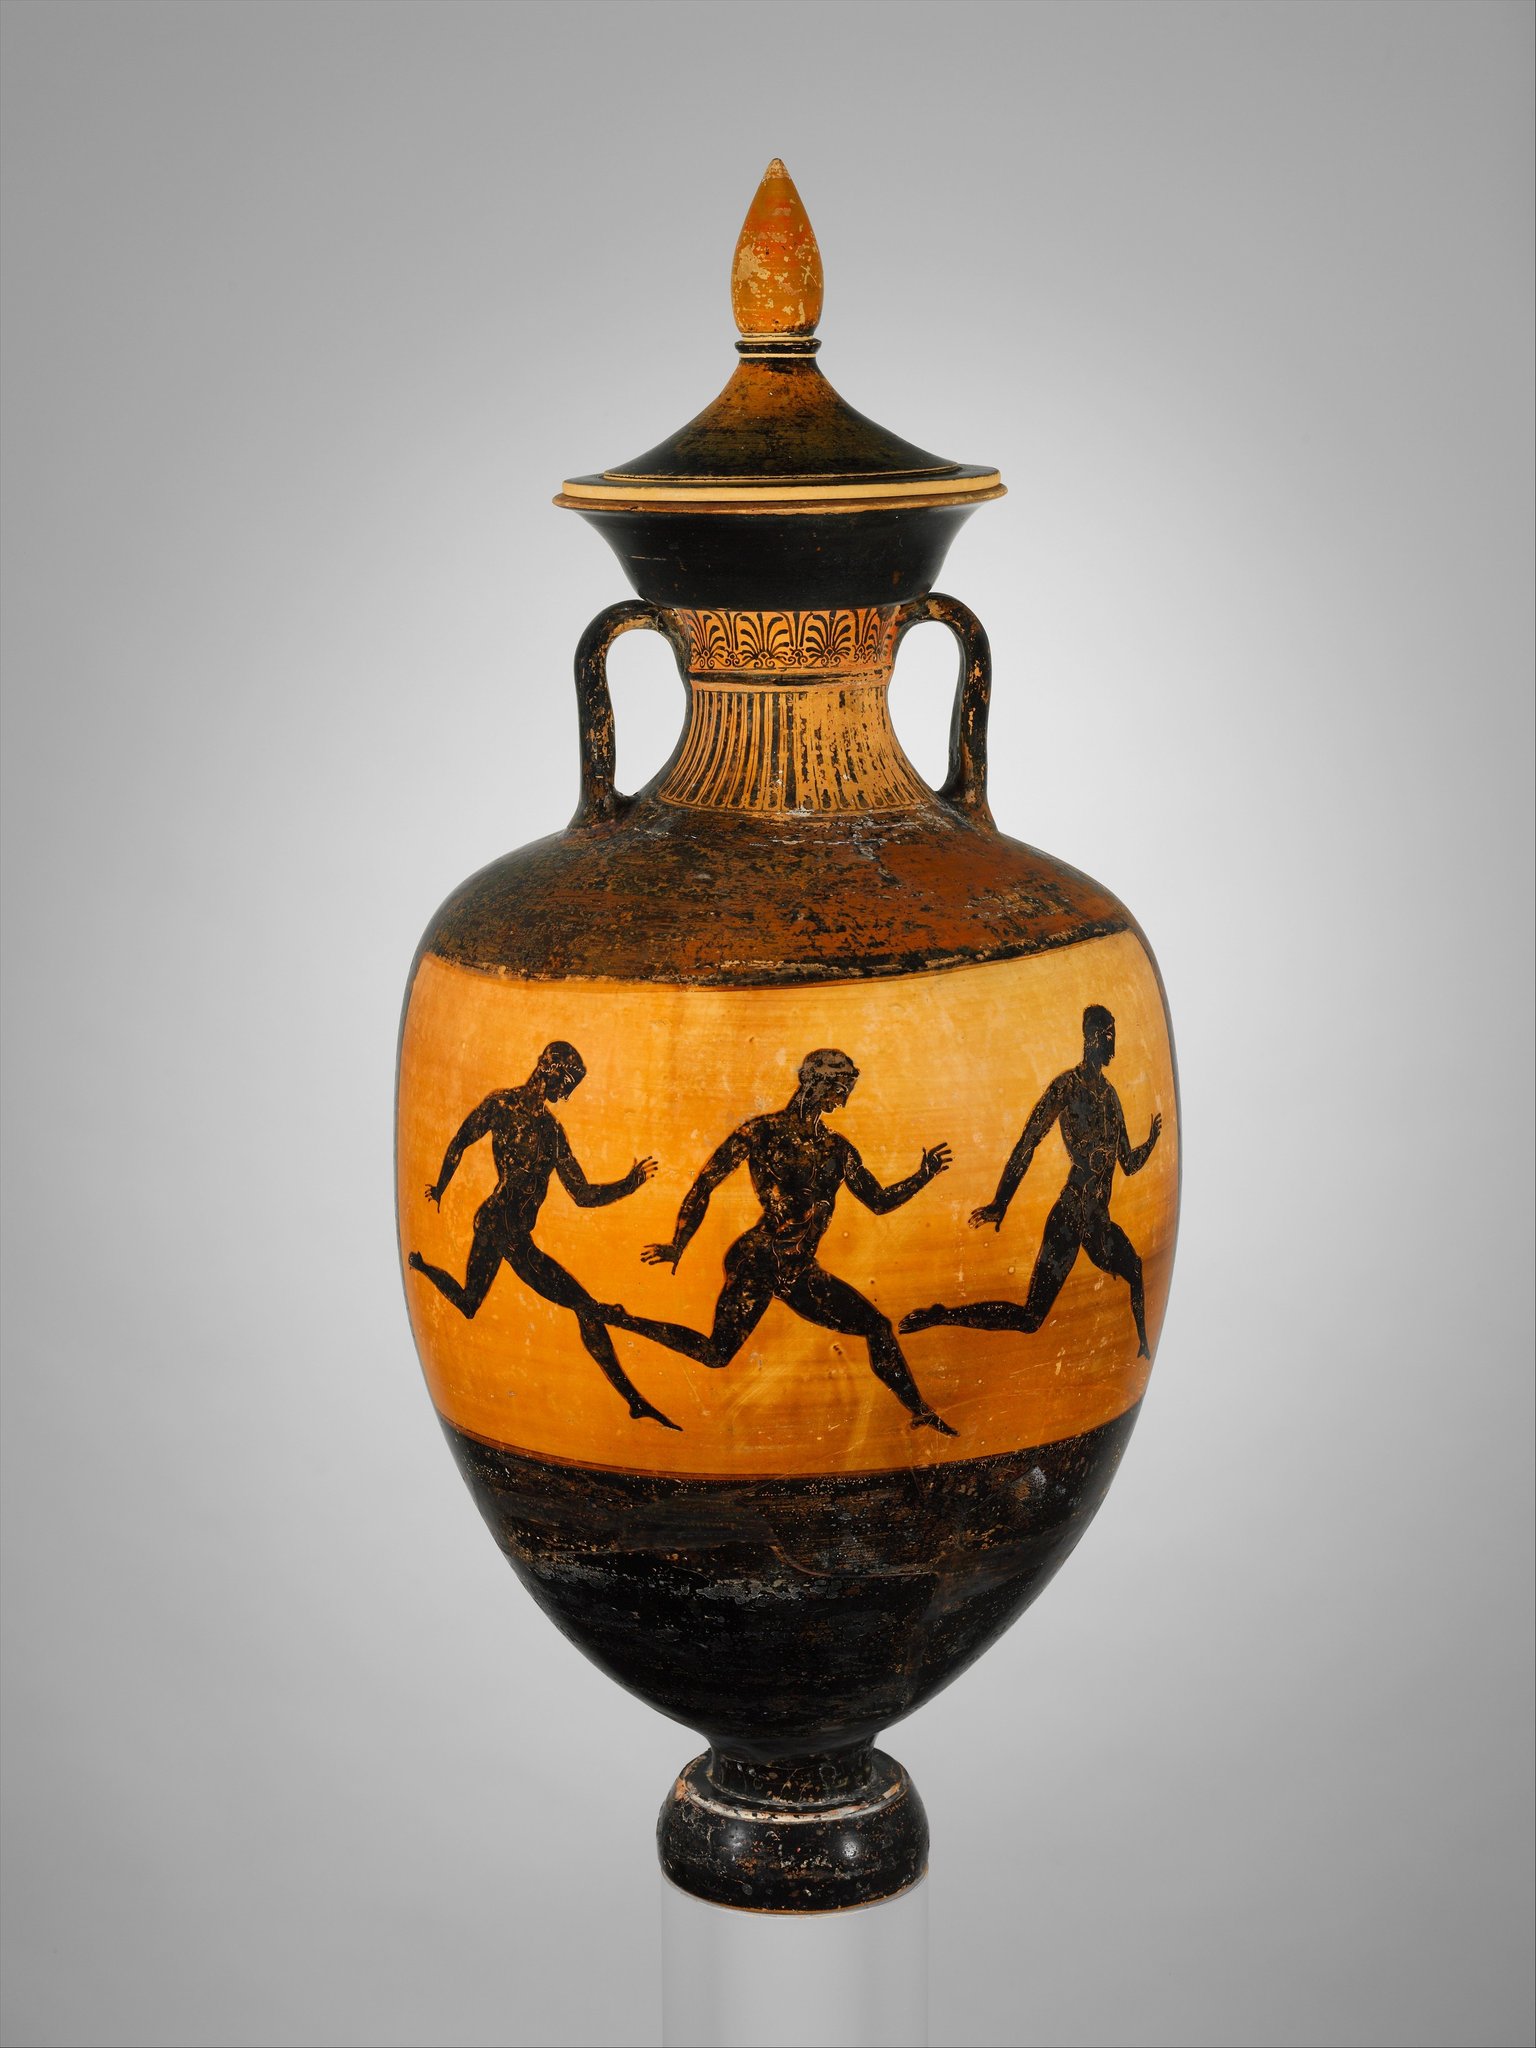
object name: panathenaic prize amphora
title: Terracotta Panathenaic prize amphora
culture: greek, attic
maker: kittos group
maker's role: artist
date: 366-365 BCE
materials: terracotta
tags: shields,men,running,athena,athletes